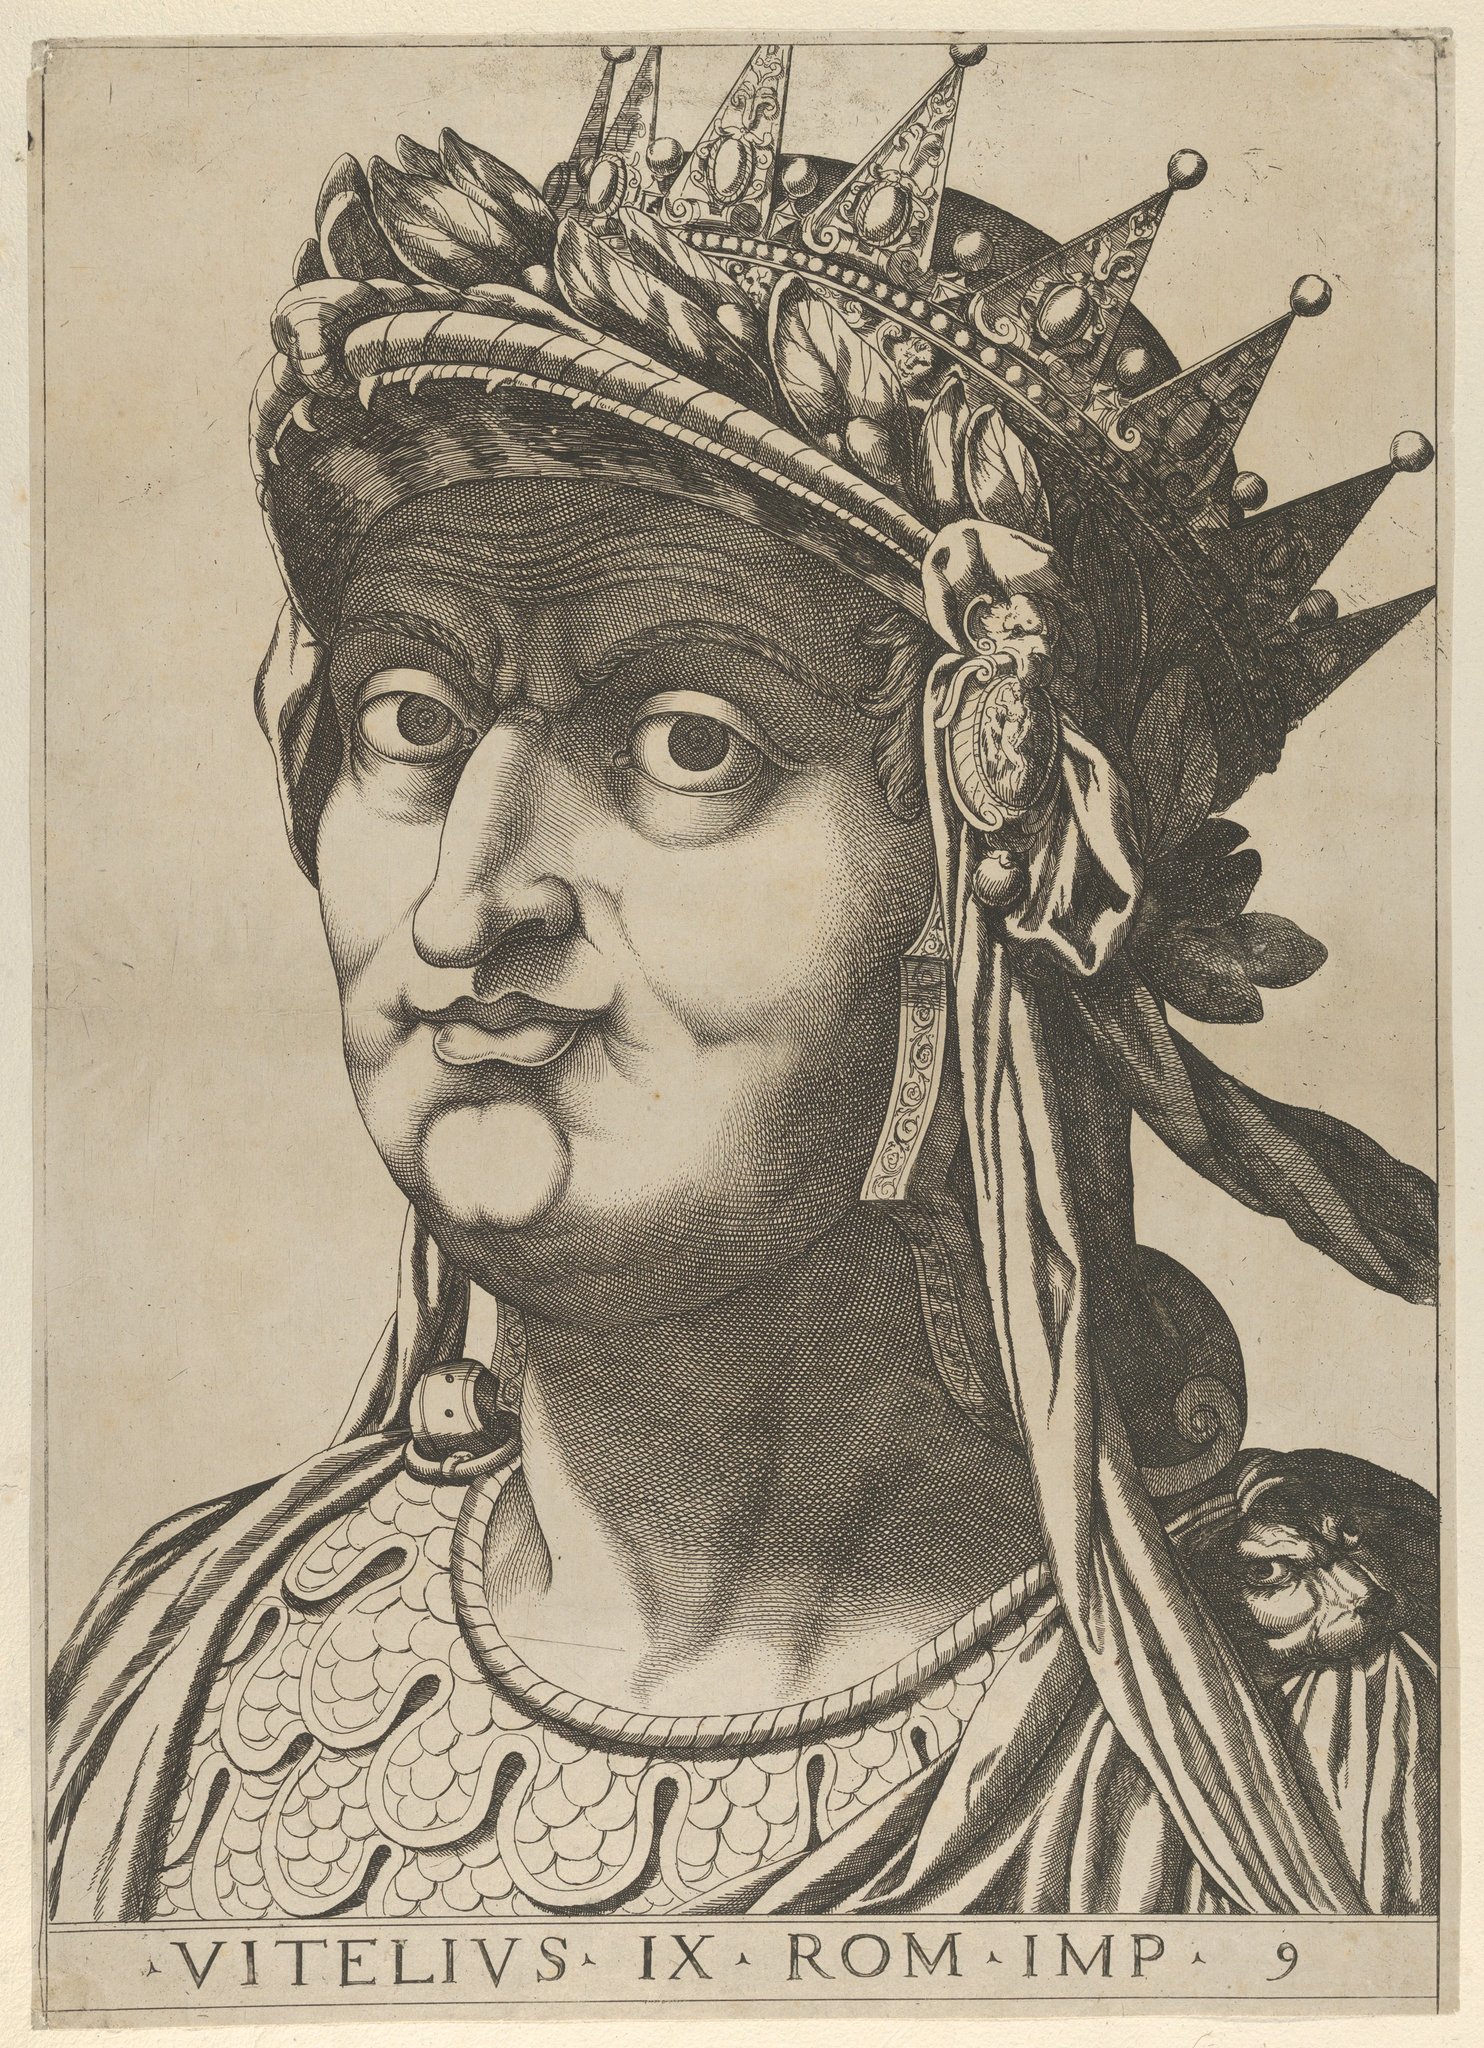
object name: print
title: Plate 9: Aulus Vitellius with his head turned slightly to the left, from "The Twelve Caesars"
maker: Anonymous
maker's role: artist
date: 1610-1640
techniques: engraving, etching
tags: men,portraits